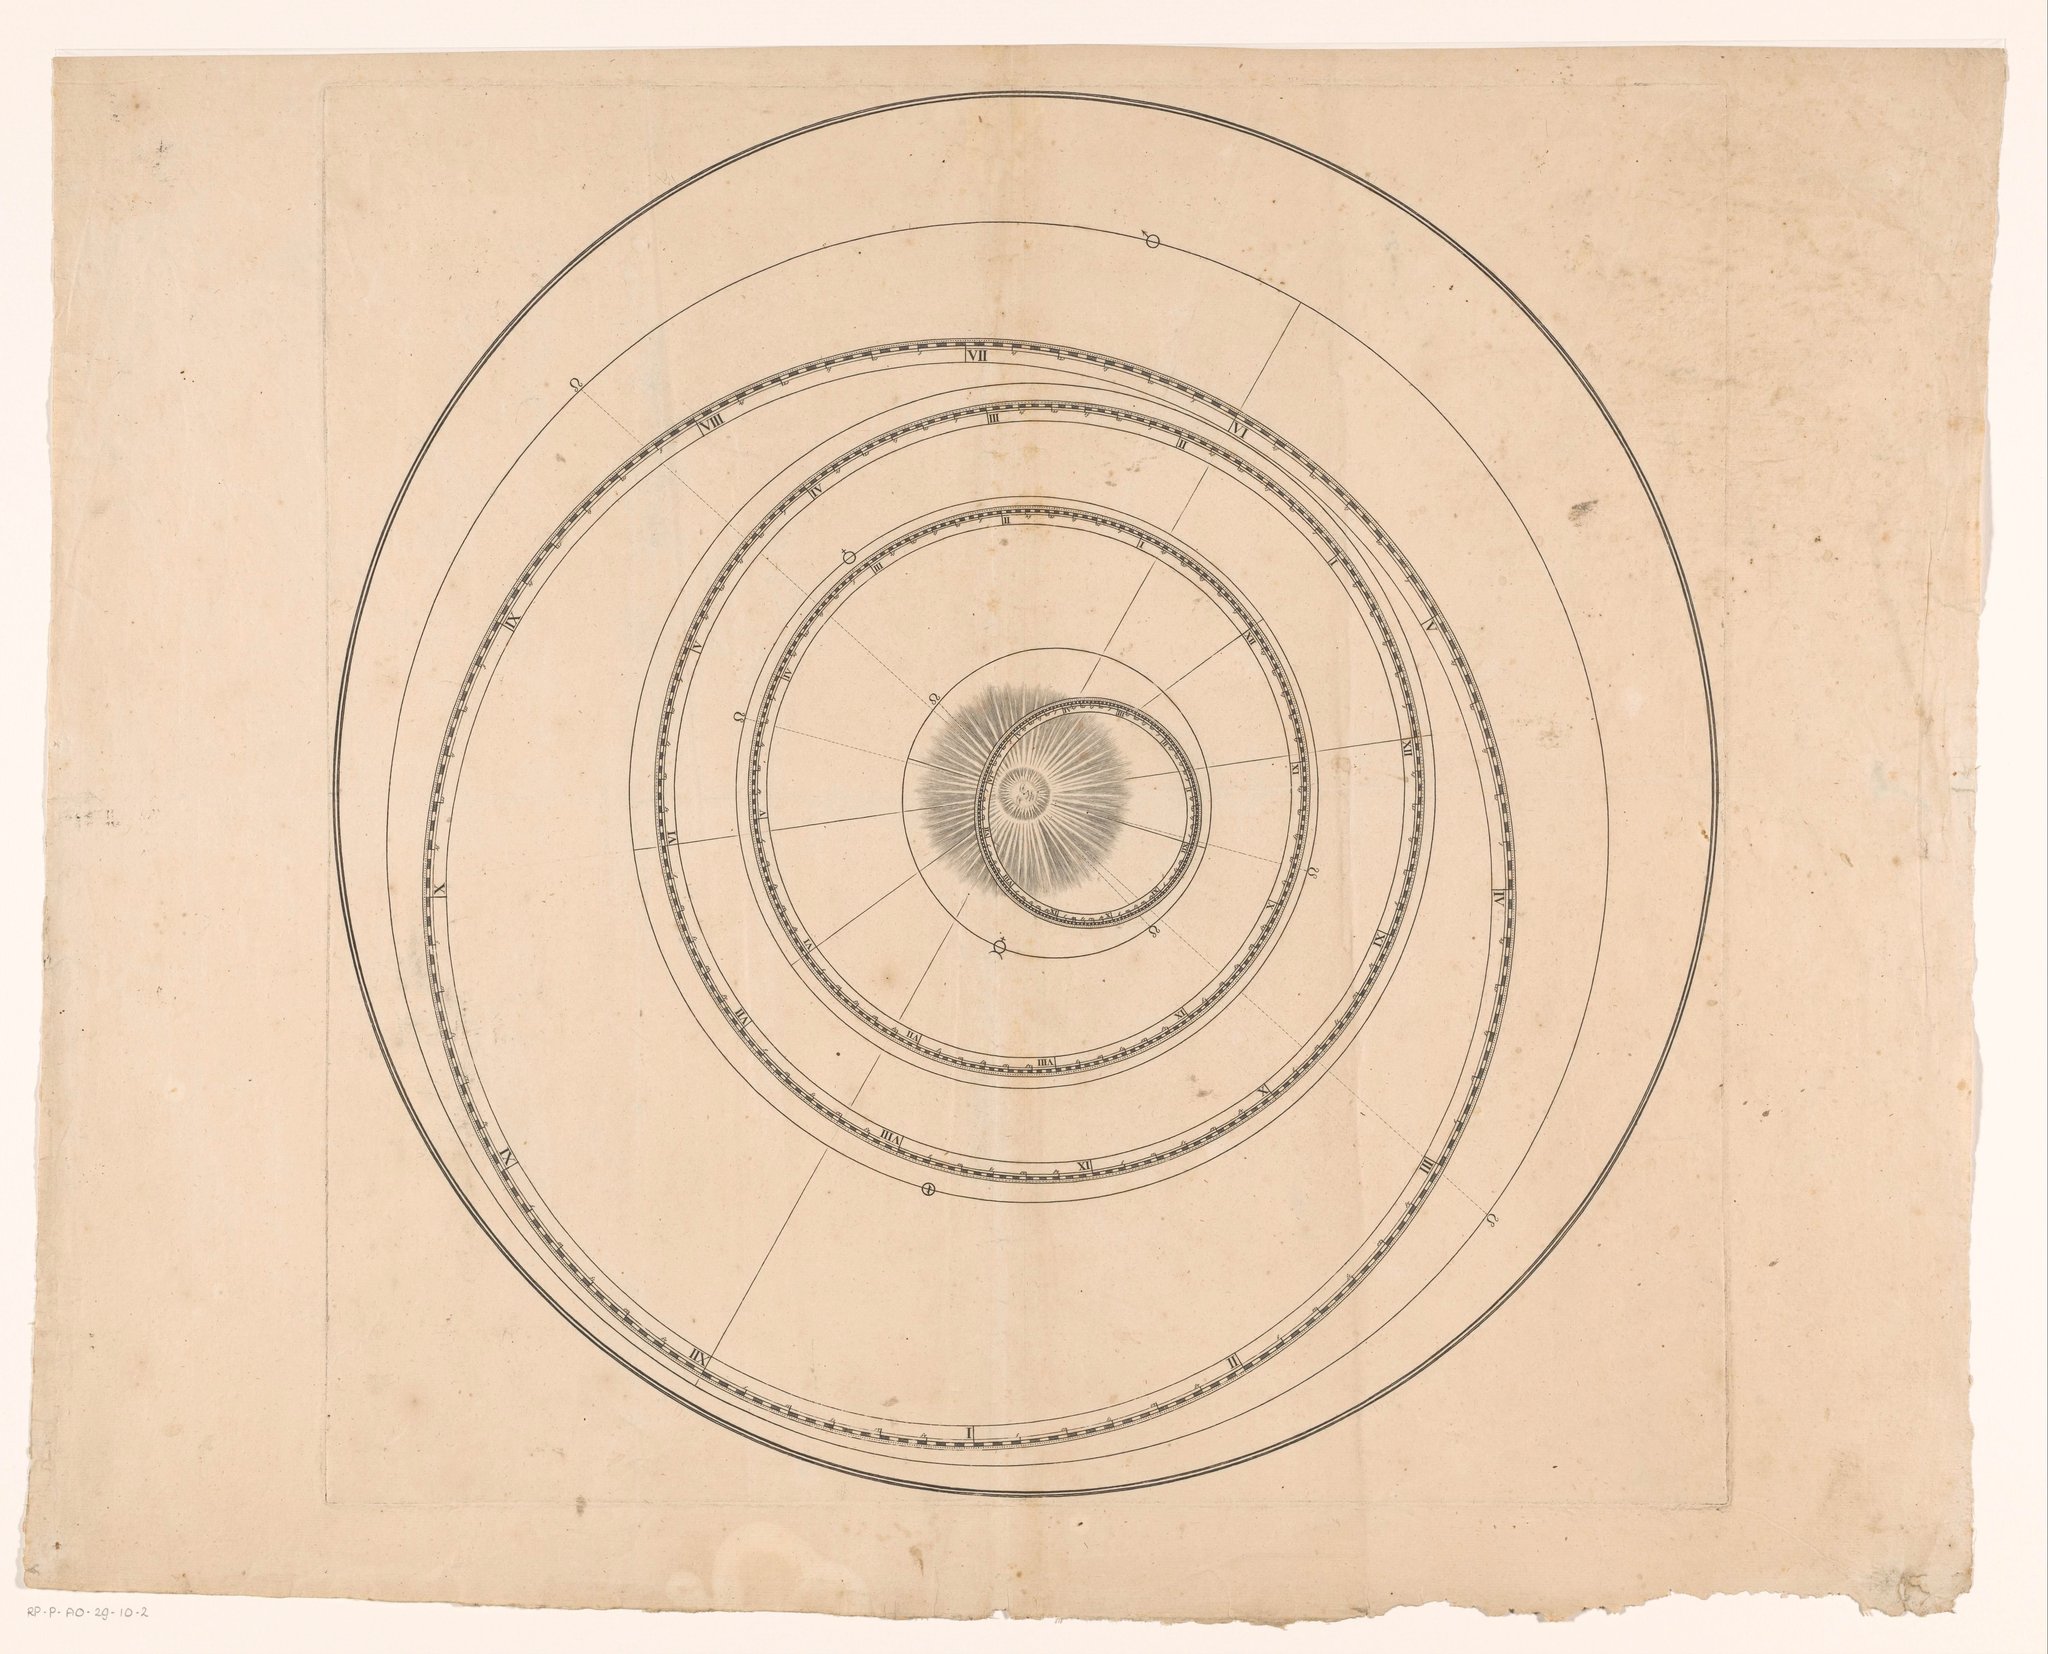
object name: map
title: Sisto tibi hic organum plané novum, mi astrophile (...)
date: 1695-1726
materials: paper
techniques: engraving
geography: amsterdam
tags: zodiac; the twelve zodiacal signs together, planets; planetary system, solar system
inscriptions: collector's mark: Lugt 2228